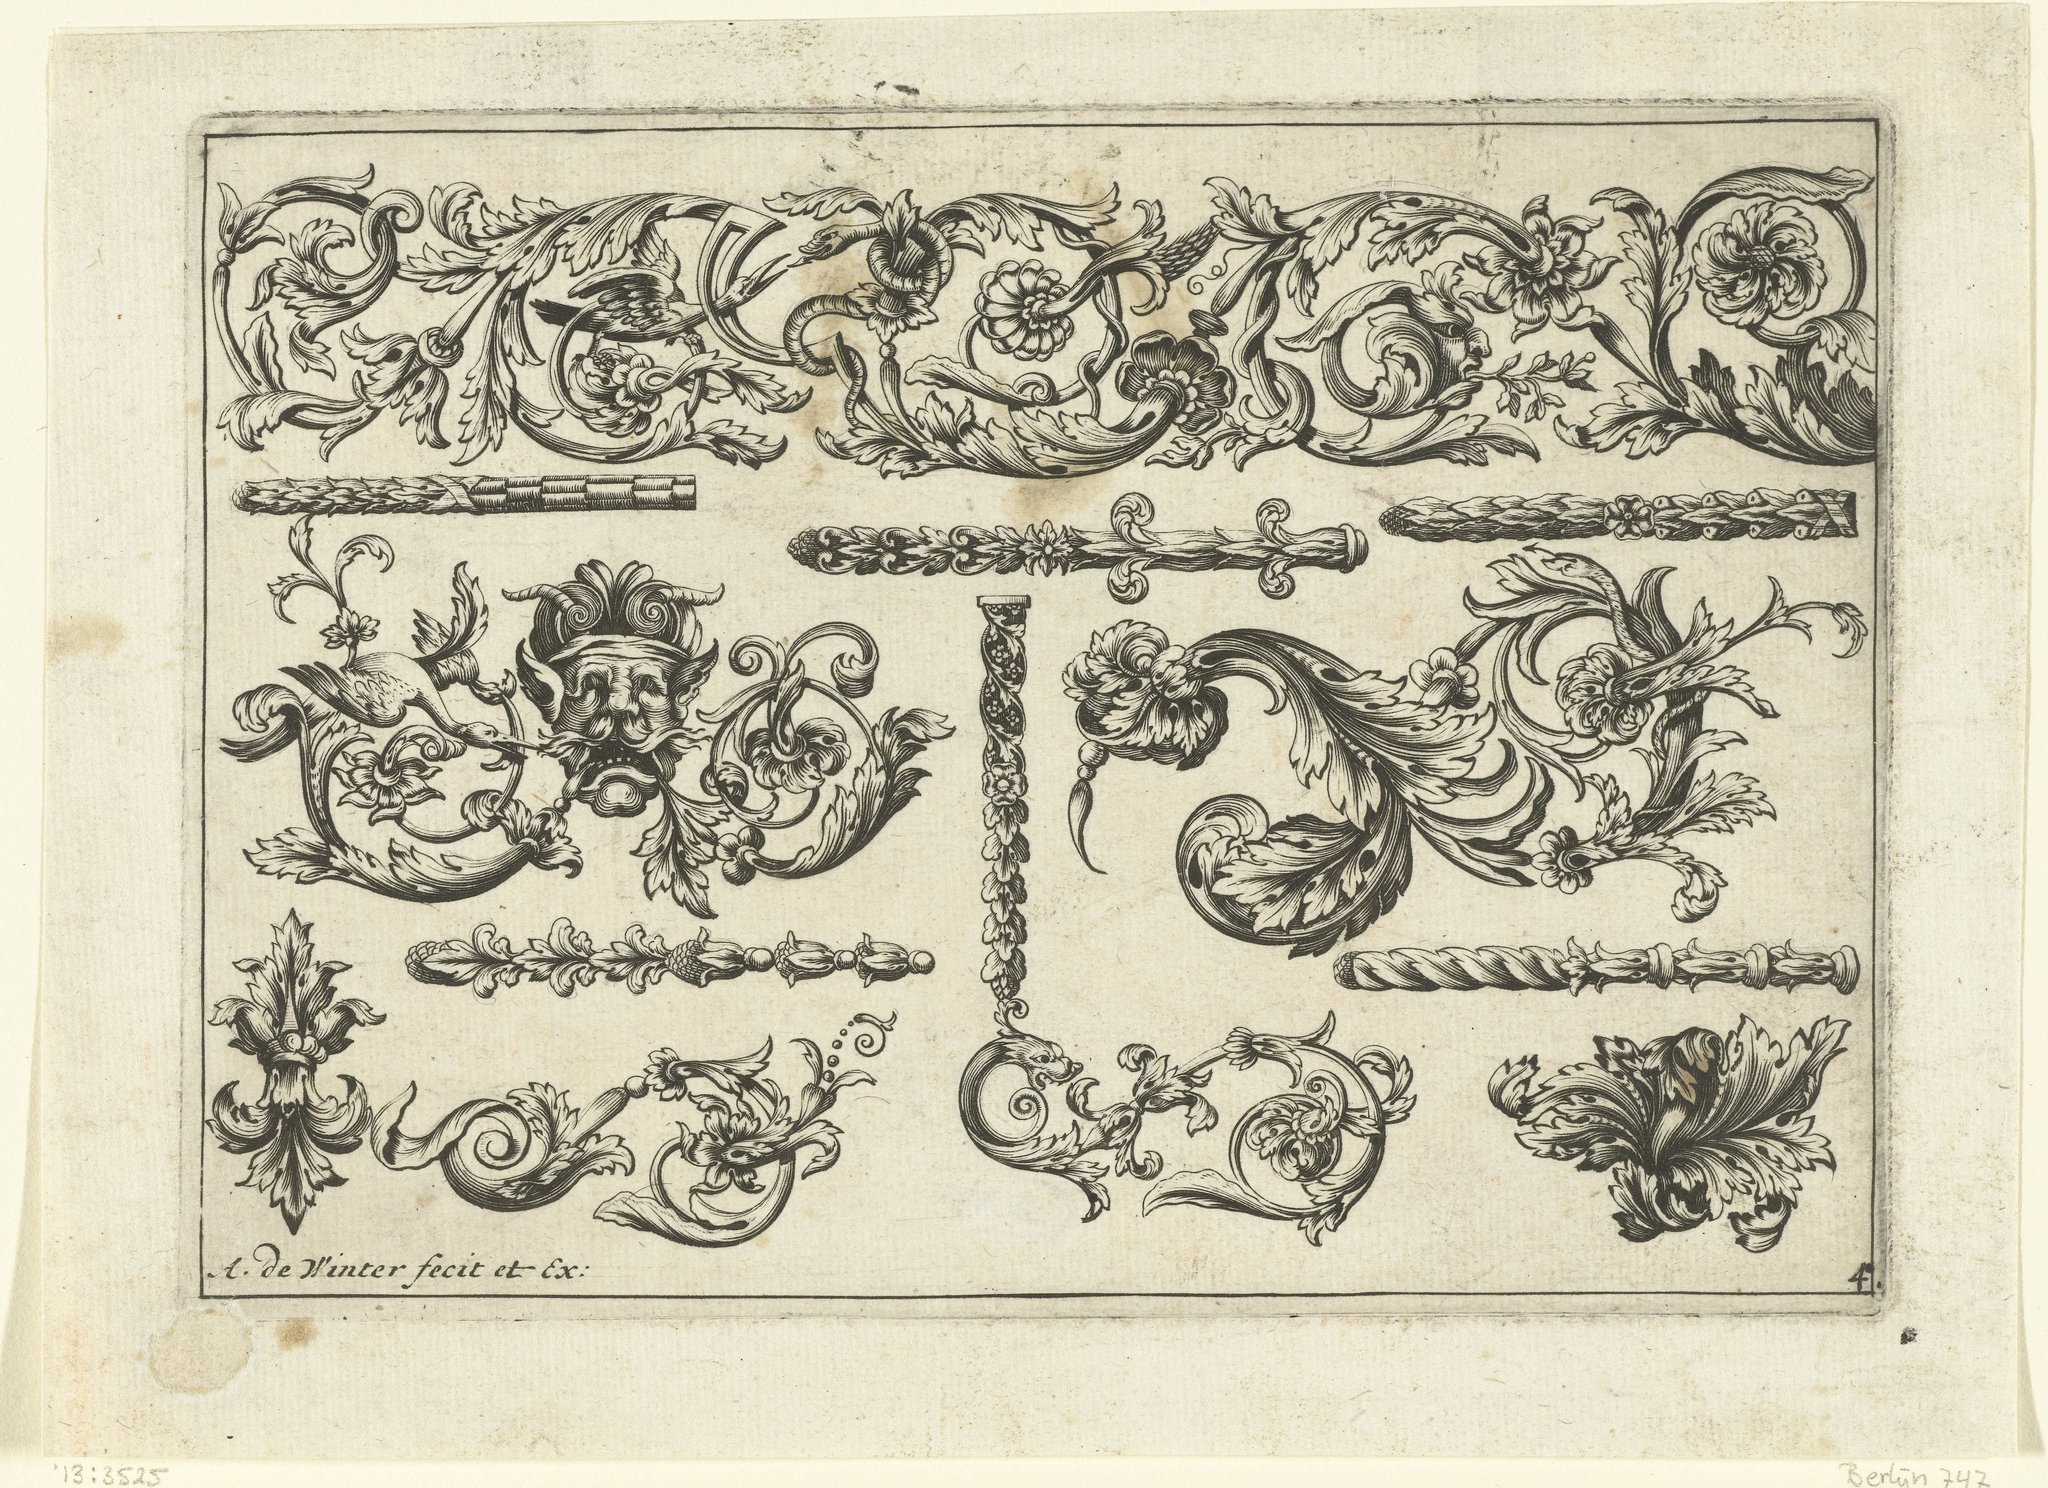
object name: ornament print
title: Dertien motieven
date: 1690-1700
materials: paper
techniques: engraving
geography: amsterdam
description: Bovenaan een fries van bladranken, vijf motieven met ranken, een krans van ranken en zes ornamentele randen met variaties. Blad uit serie met kopieën naar Stefano della Bella, Gilles Légaré, Thomas Lejuge en anderen.